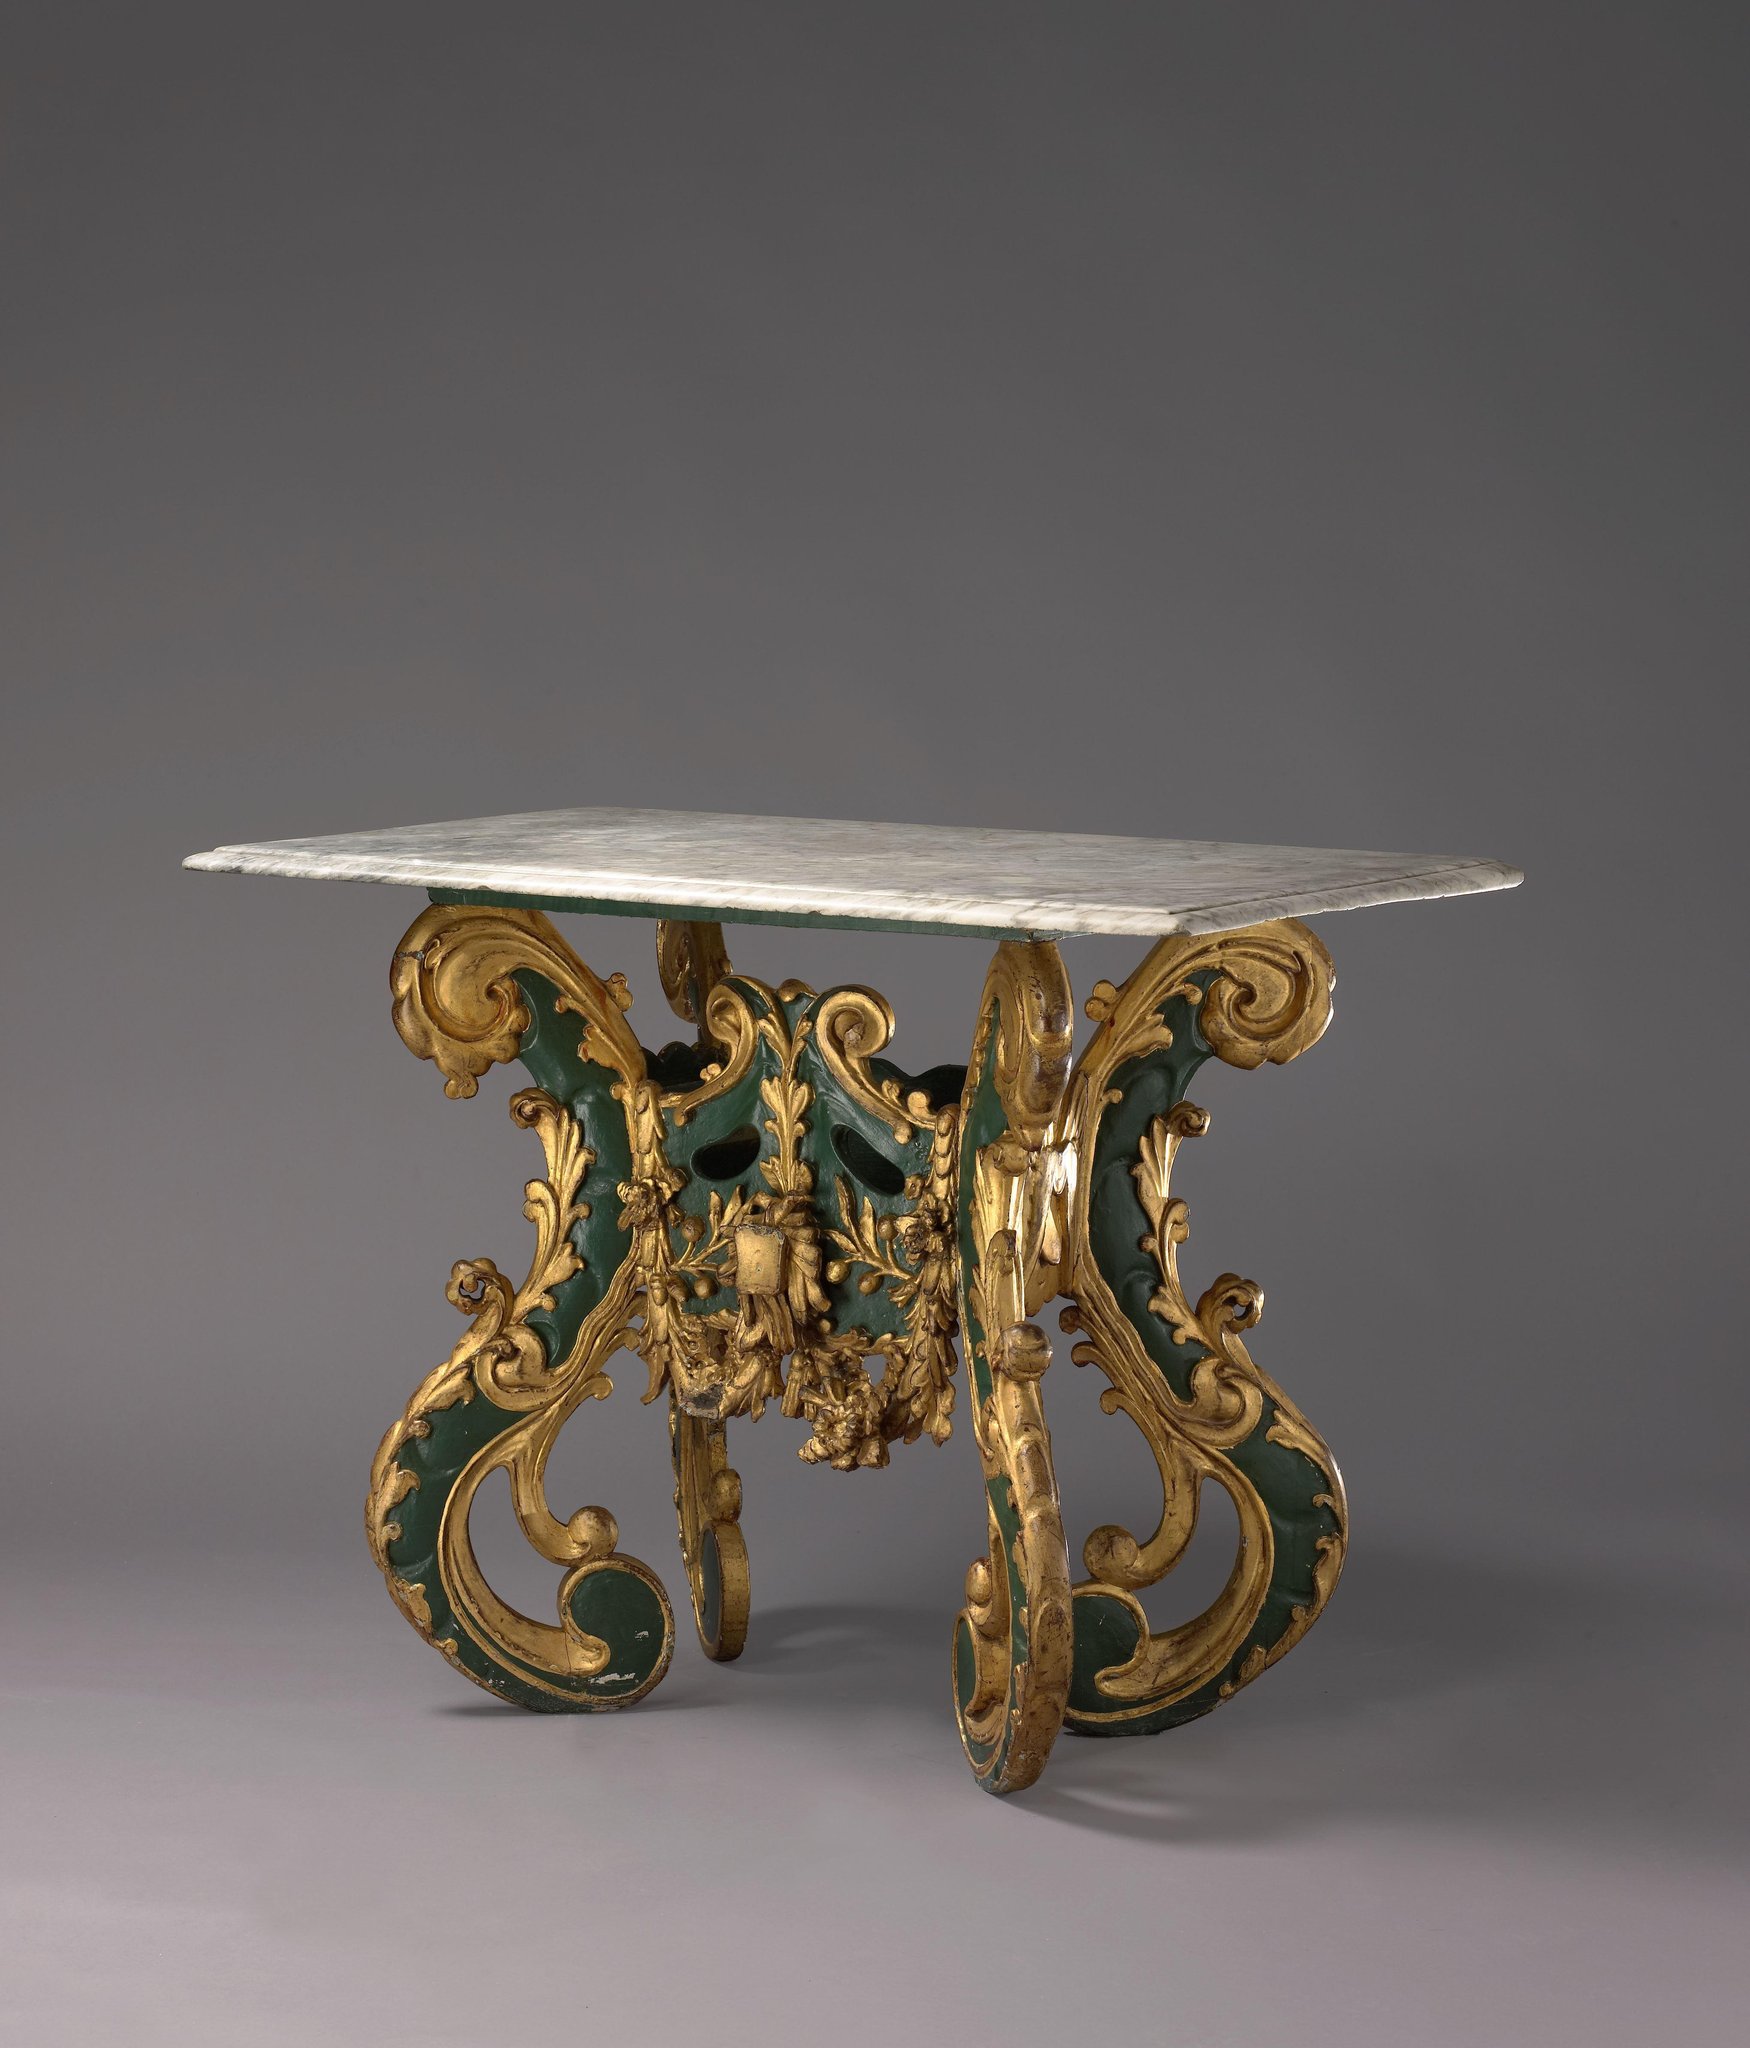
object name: tabletop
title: Tafelblad van wandtafel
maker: Anonymous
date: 1655-1675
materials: marble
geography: netherlands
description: Marmeren tafelbad van tafel van beschilderd notenhout op vier overhoeks geplaatste S-vormige poten, versierd met acanthusblad en kwabornament en verbonden door regels.